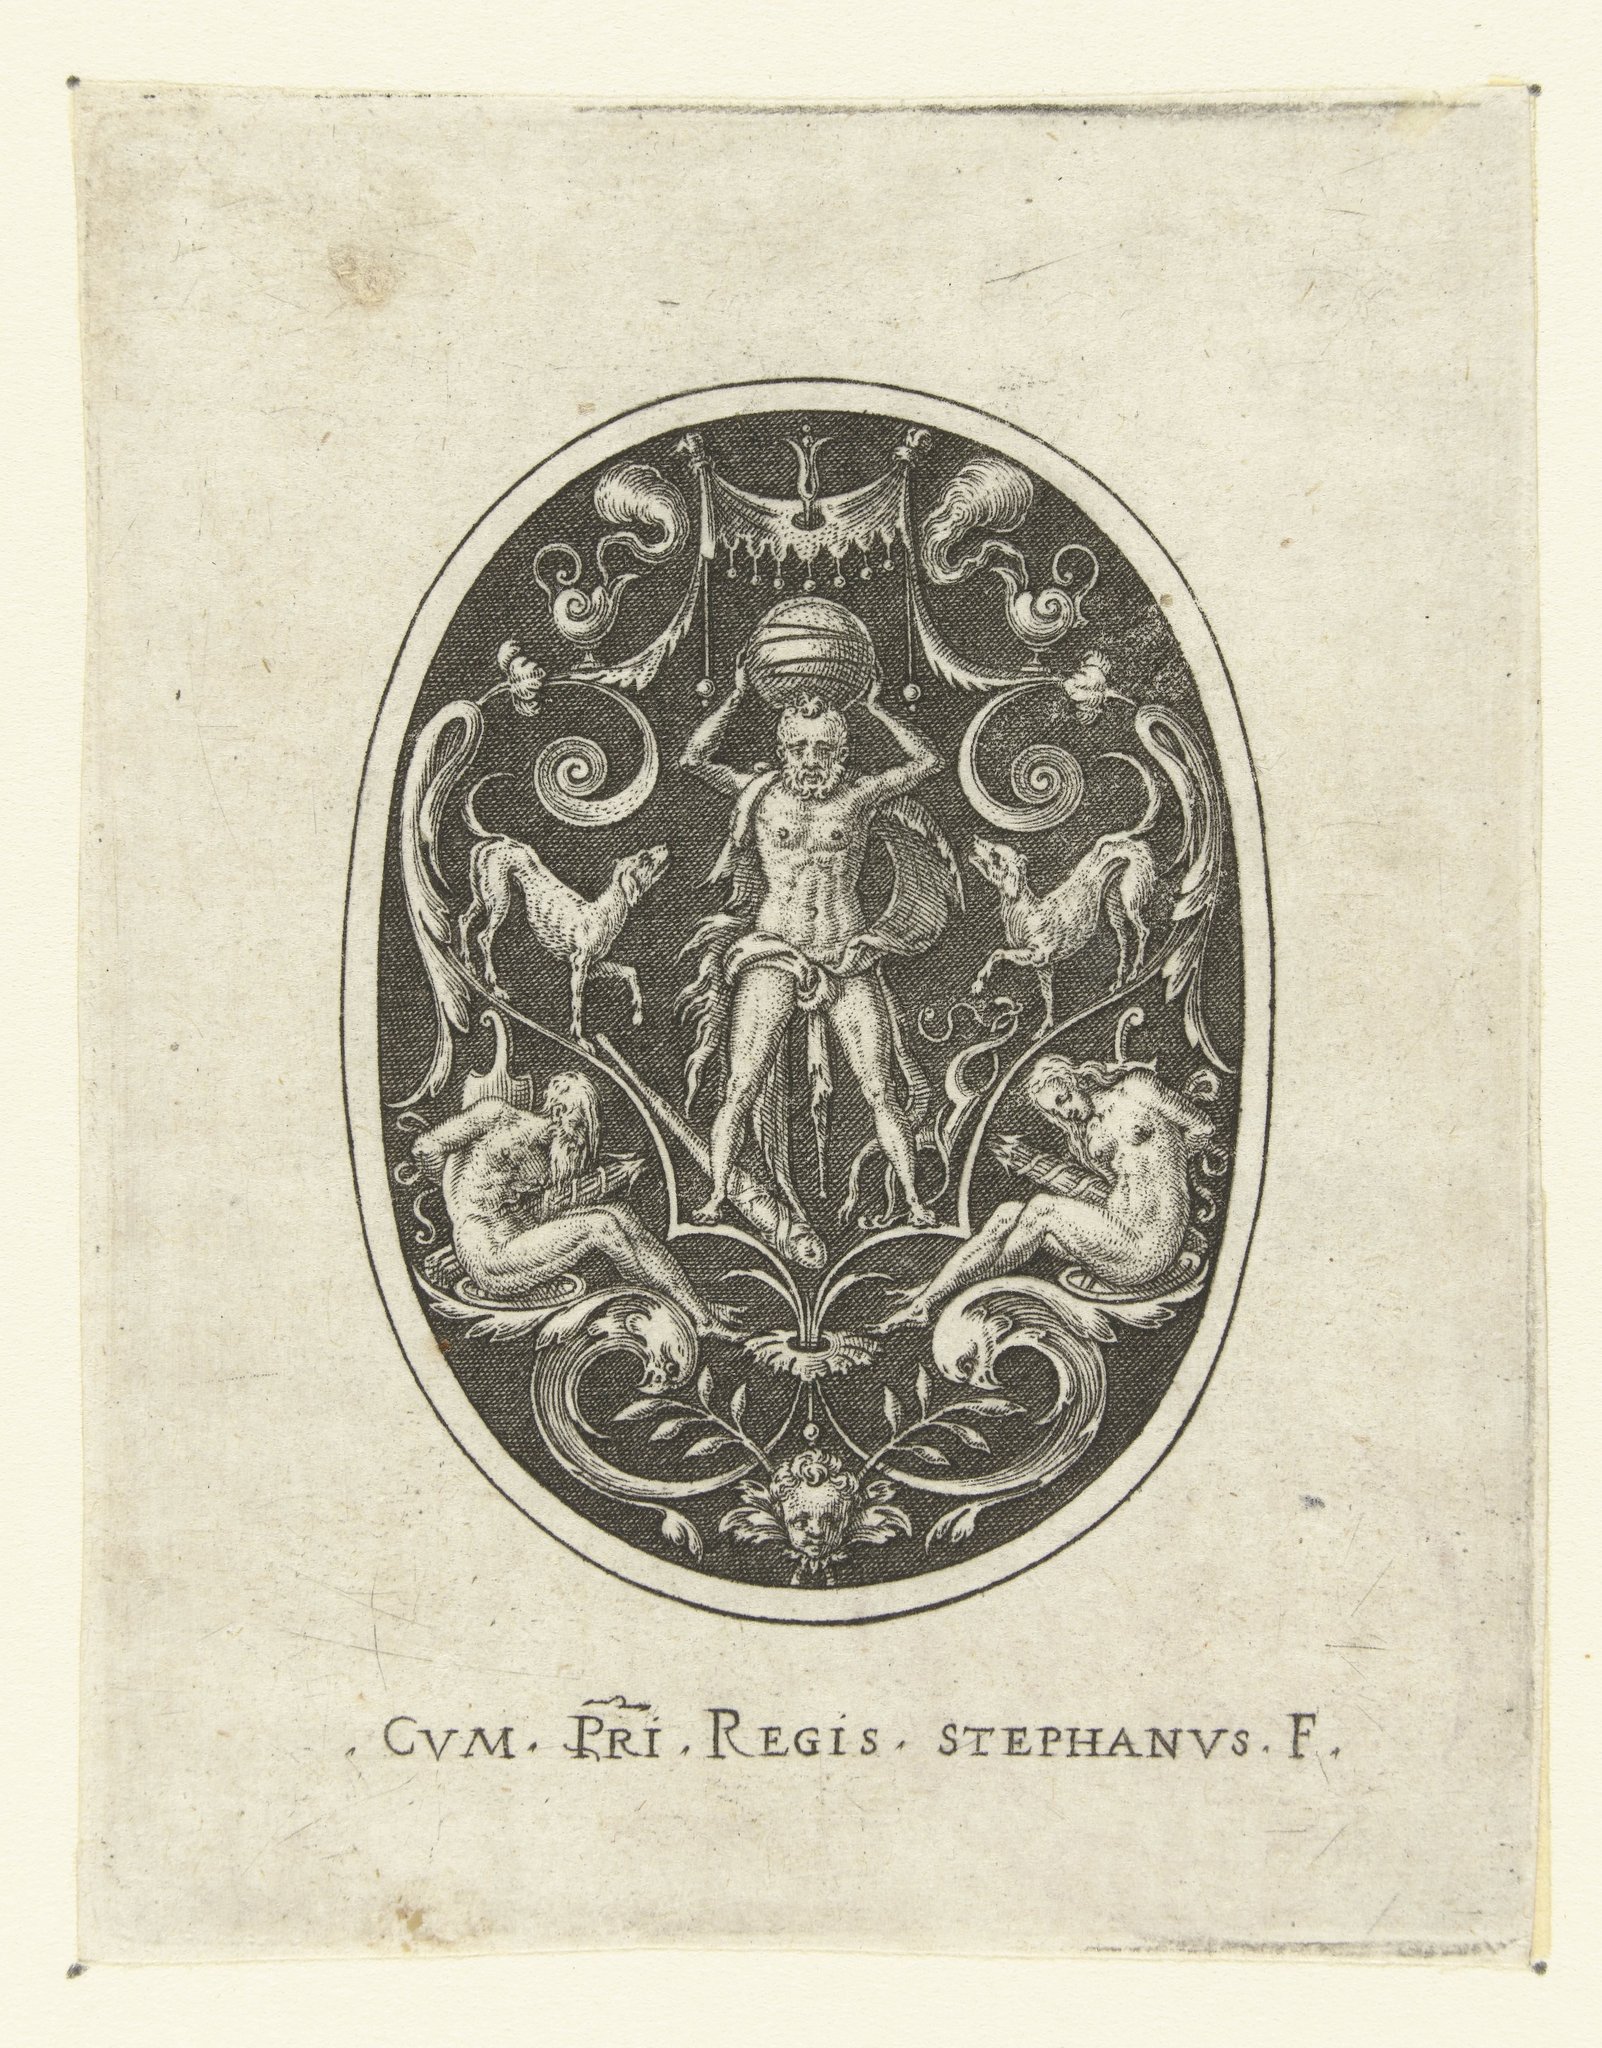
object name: ornament print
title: Hercules met de aardbol op zijn hoofd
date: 1528-1583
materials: paper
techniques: engraving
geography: france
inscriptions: collector's mark: Lugt 240